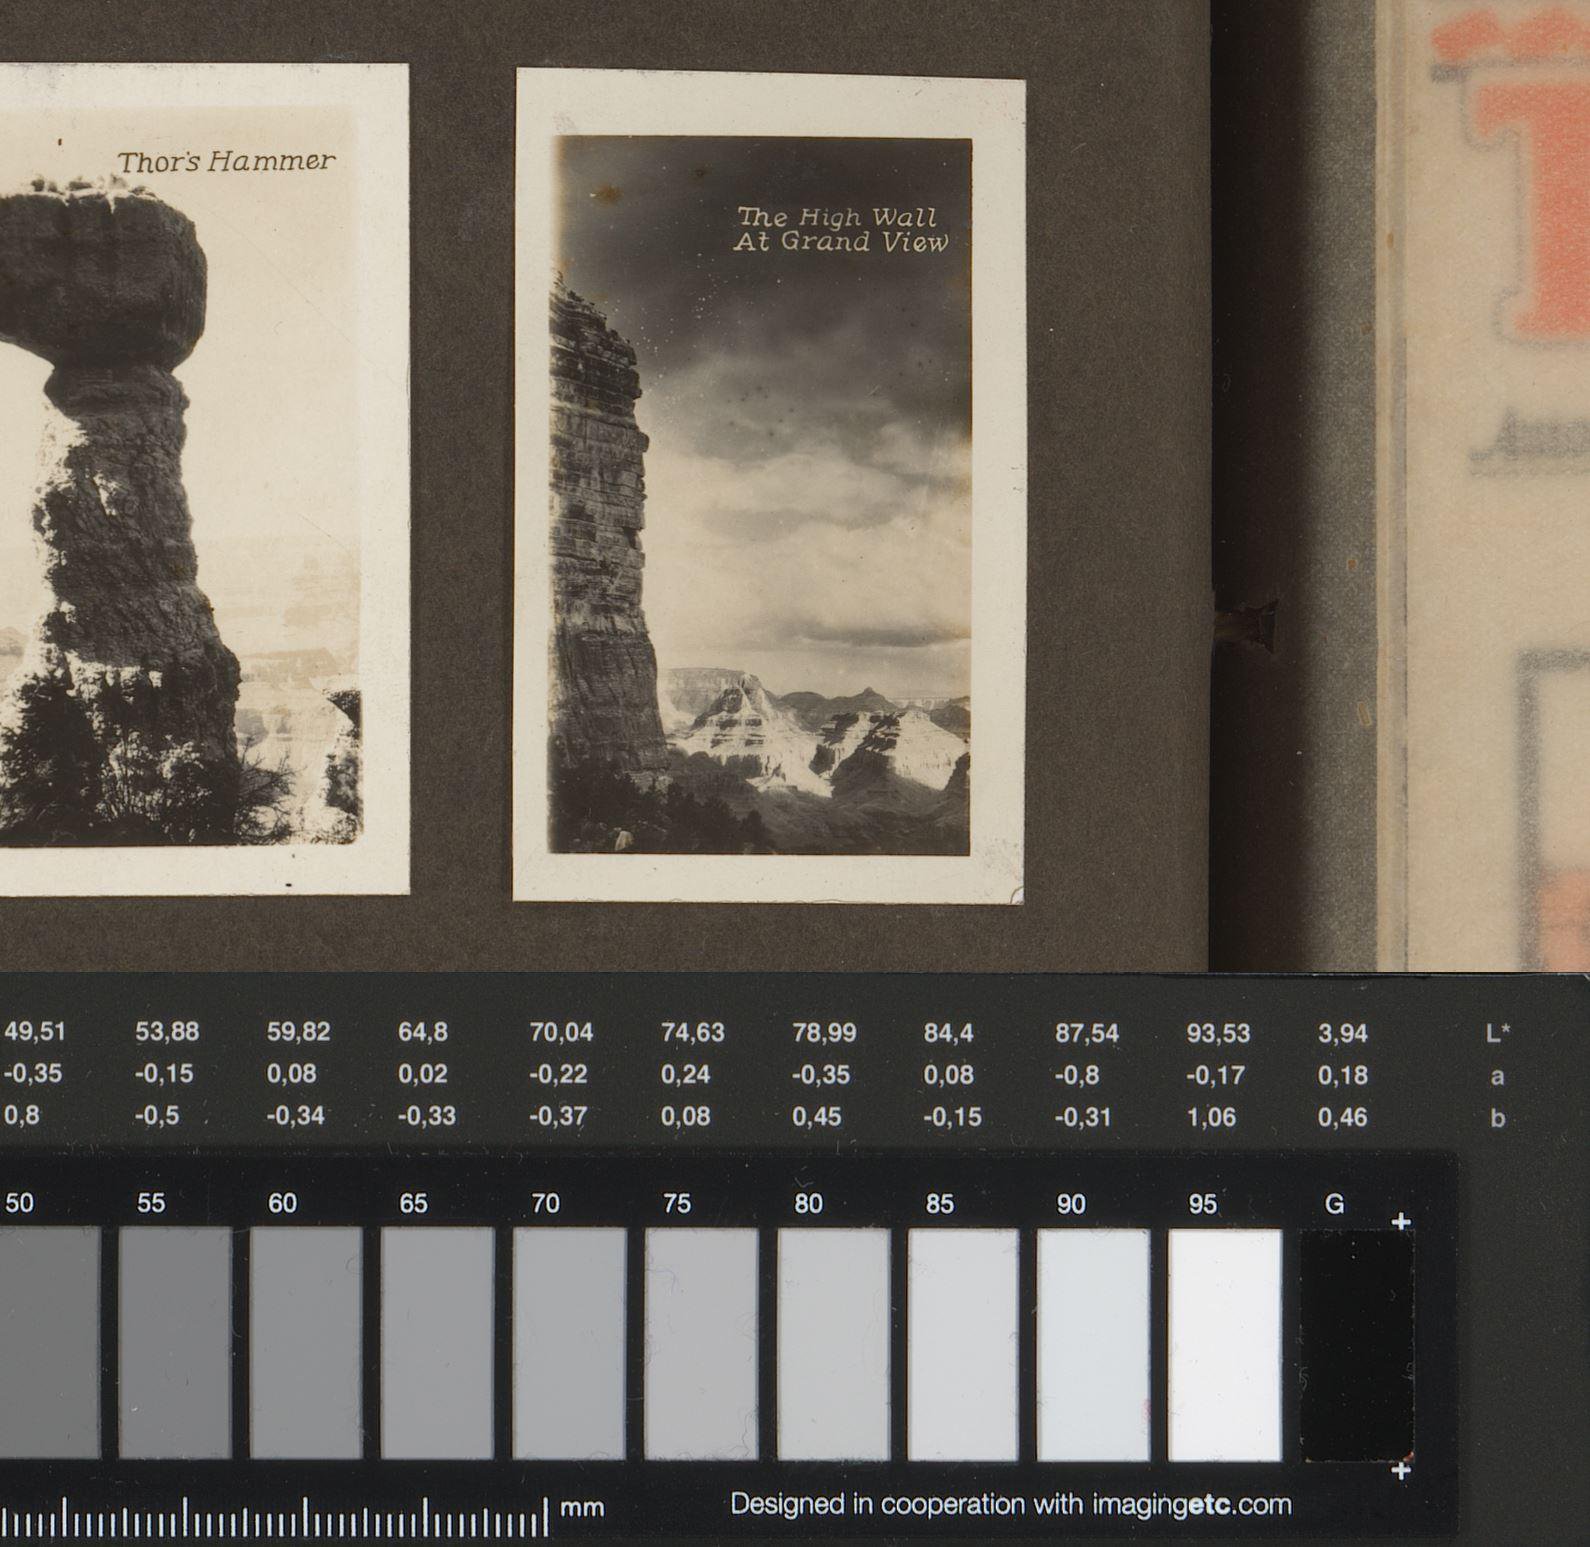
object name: photograph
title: The high wall at grand view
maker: Anonymous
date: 1928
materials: photographic support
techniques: gelatin silver print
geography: grand canyon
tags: ravine, chasm, abyss, canyon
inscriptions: annotation: ‘Grand Canyon’